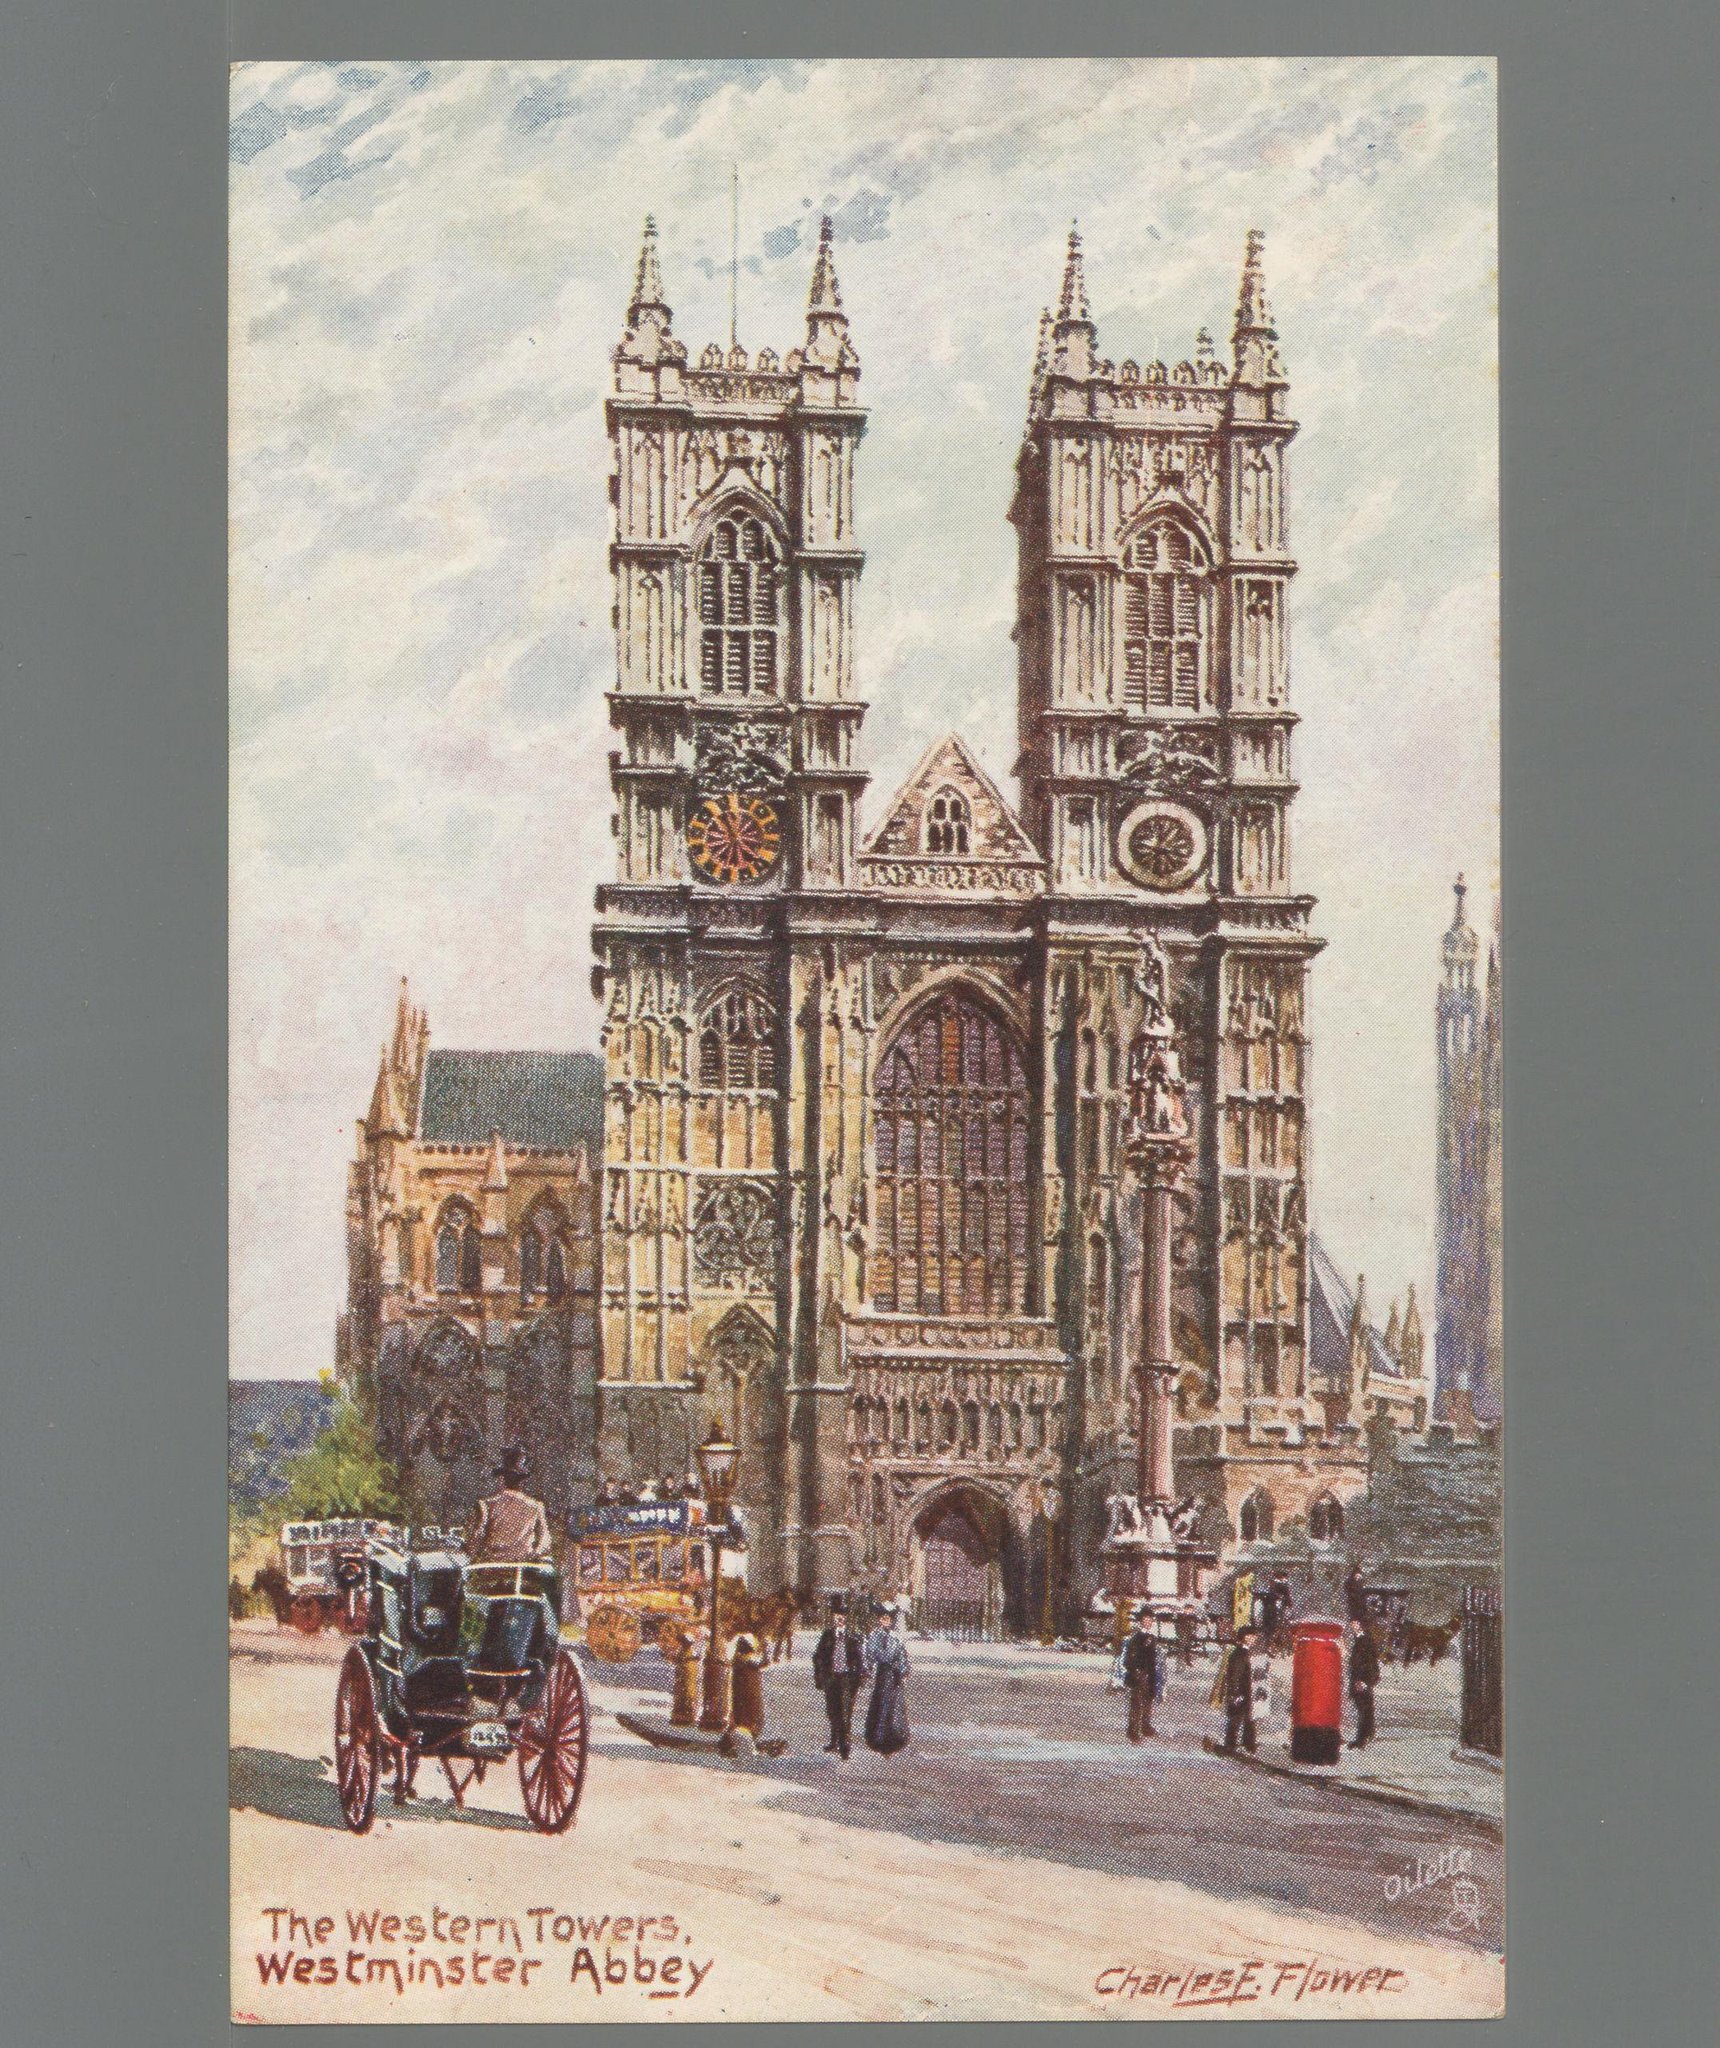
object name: photomechanical print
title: Oilette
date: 1908-1930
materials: cardboard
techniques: color autotype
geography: london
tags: square, place, circus, etc., church (exterior), monument, statue, westminster abbey